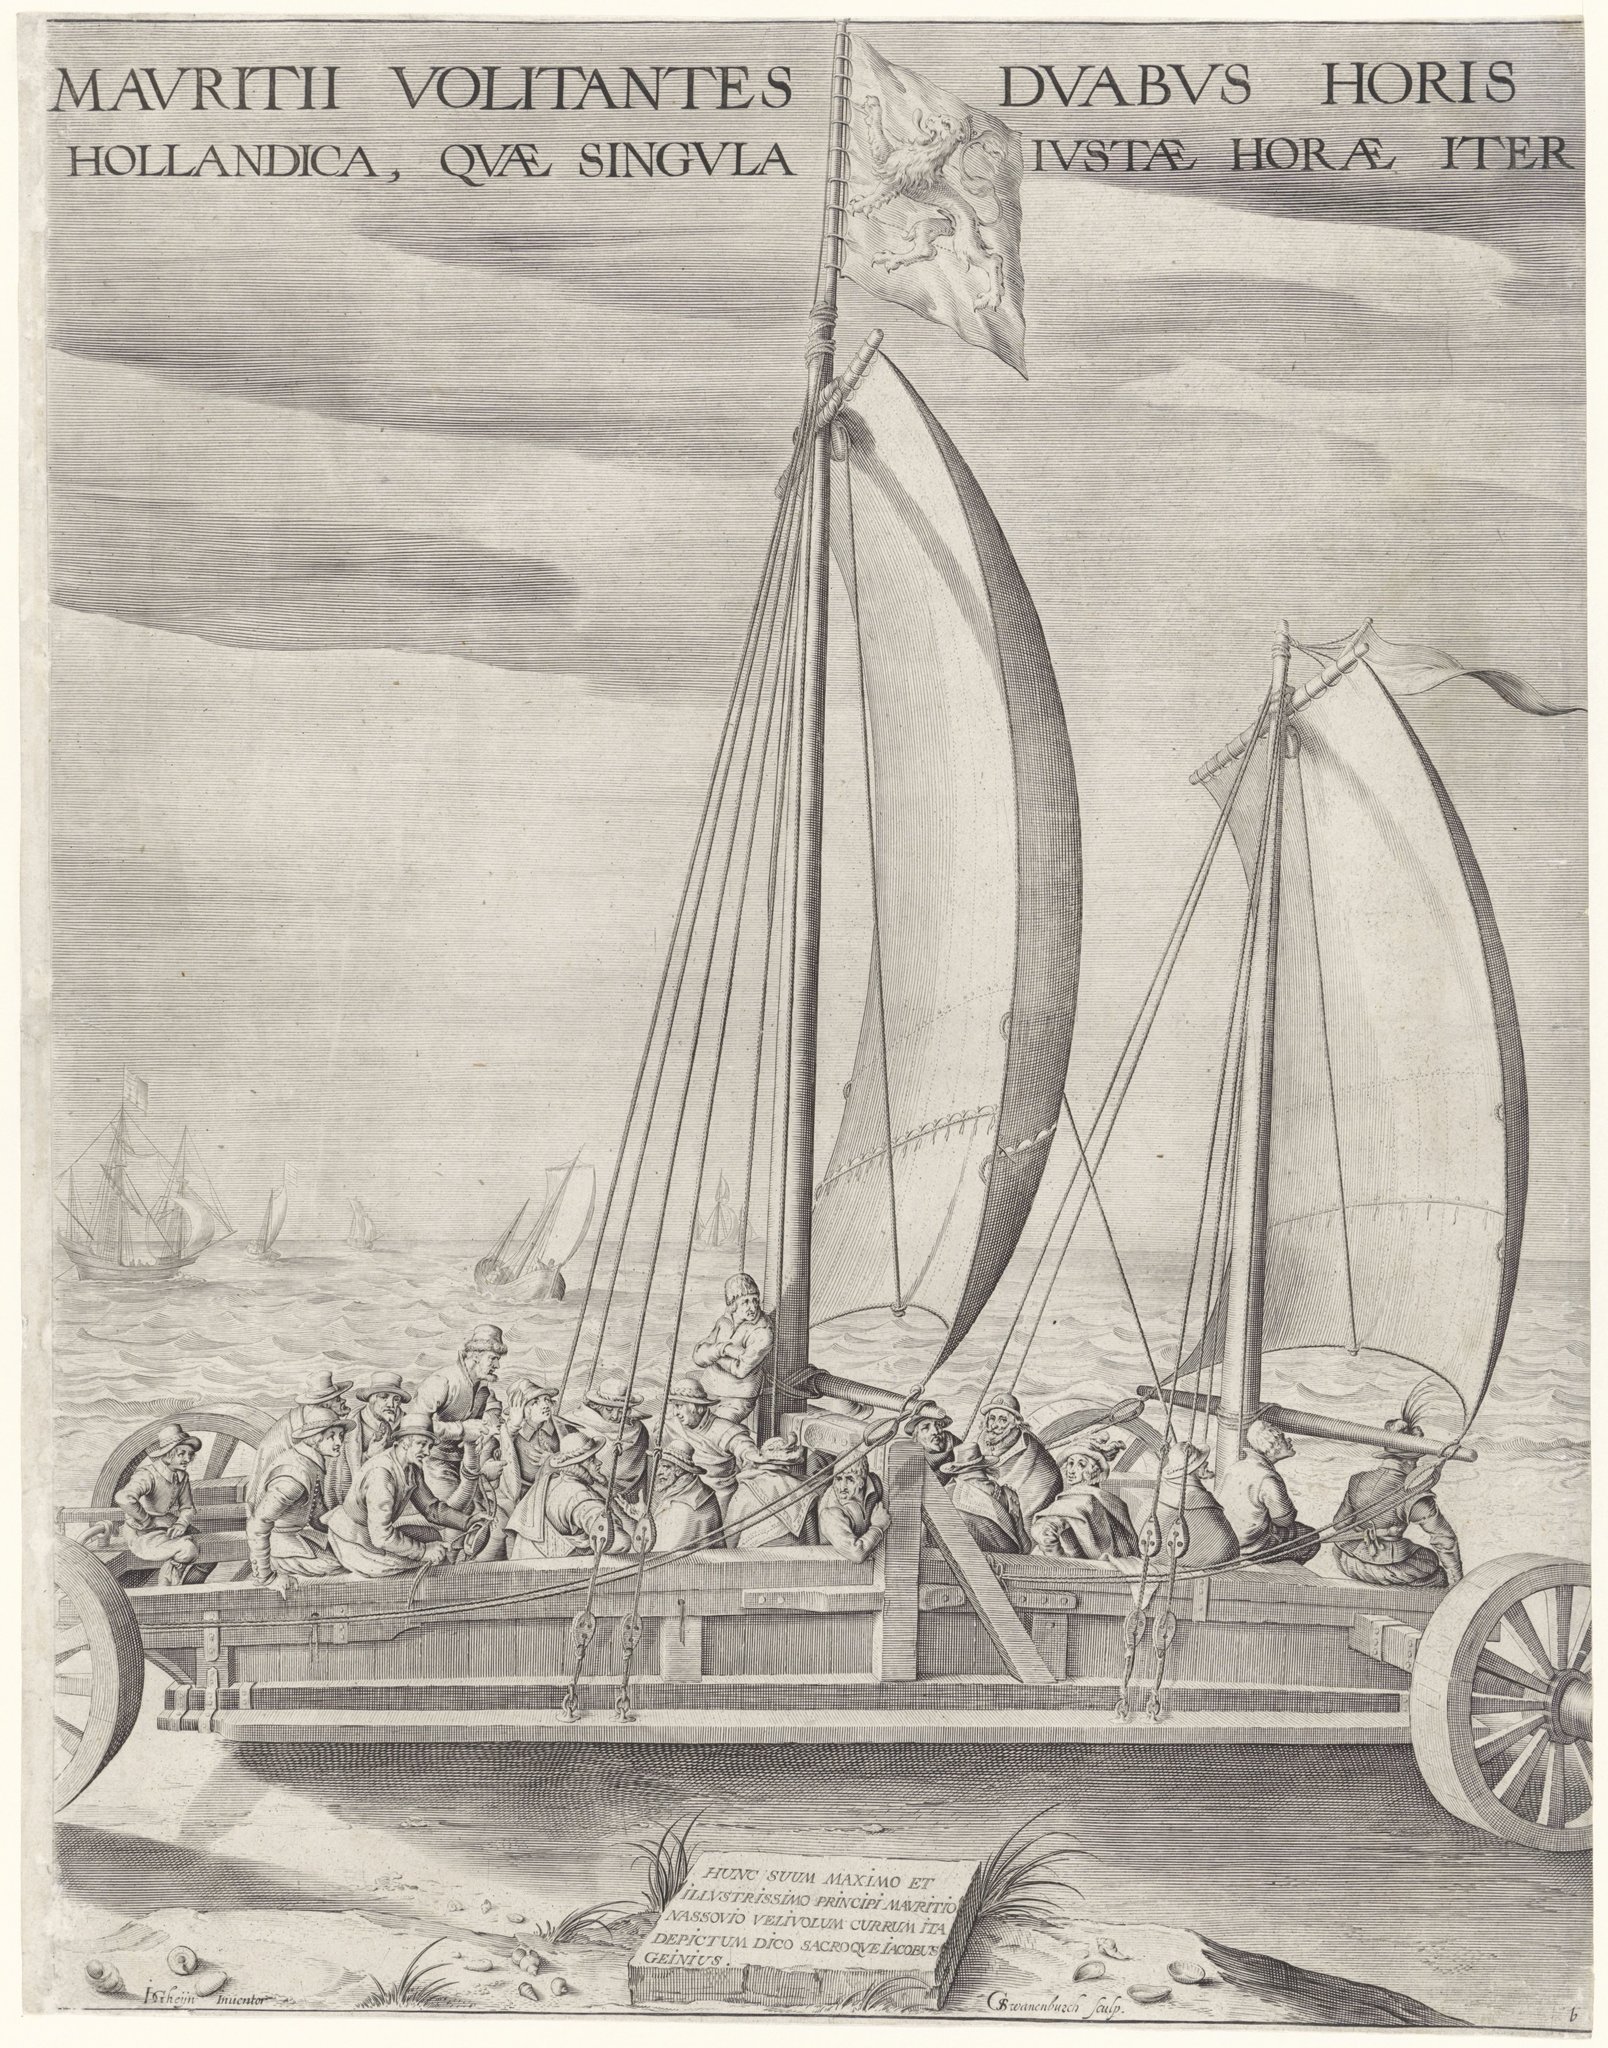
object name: history print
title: Currus veliferi illustrissimi principis Mauritii volitantes duabus horis Scheverina Pettemum ad quatuordecim milliaria Hollandica, quae singula iustae horae iter excedunt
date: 1603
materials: paper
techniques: engraving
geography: amsterdam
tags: the hague, maurice (prince of orange), bruges, simon stevin, sailing-car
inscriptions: collector's mark: Lugt 2228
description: De zeilwagen van Simon Stevin (middenplaat), 1602. Prins Maurits maakt samen met een groep vrienden een tocht over het strand van Scheveningen naar Petten in de zeilwagen gebouwd door Simon Stevin, april-mei 1602. De prins zit tussen zijn vrienden in de wagen. Op de voorgrond een stenen tablet met opschrift in het Latijn (de opdracht). Middenplaat (genummerd b) van een grote voorstelling bestaande uit drie delen.